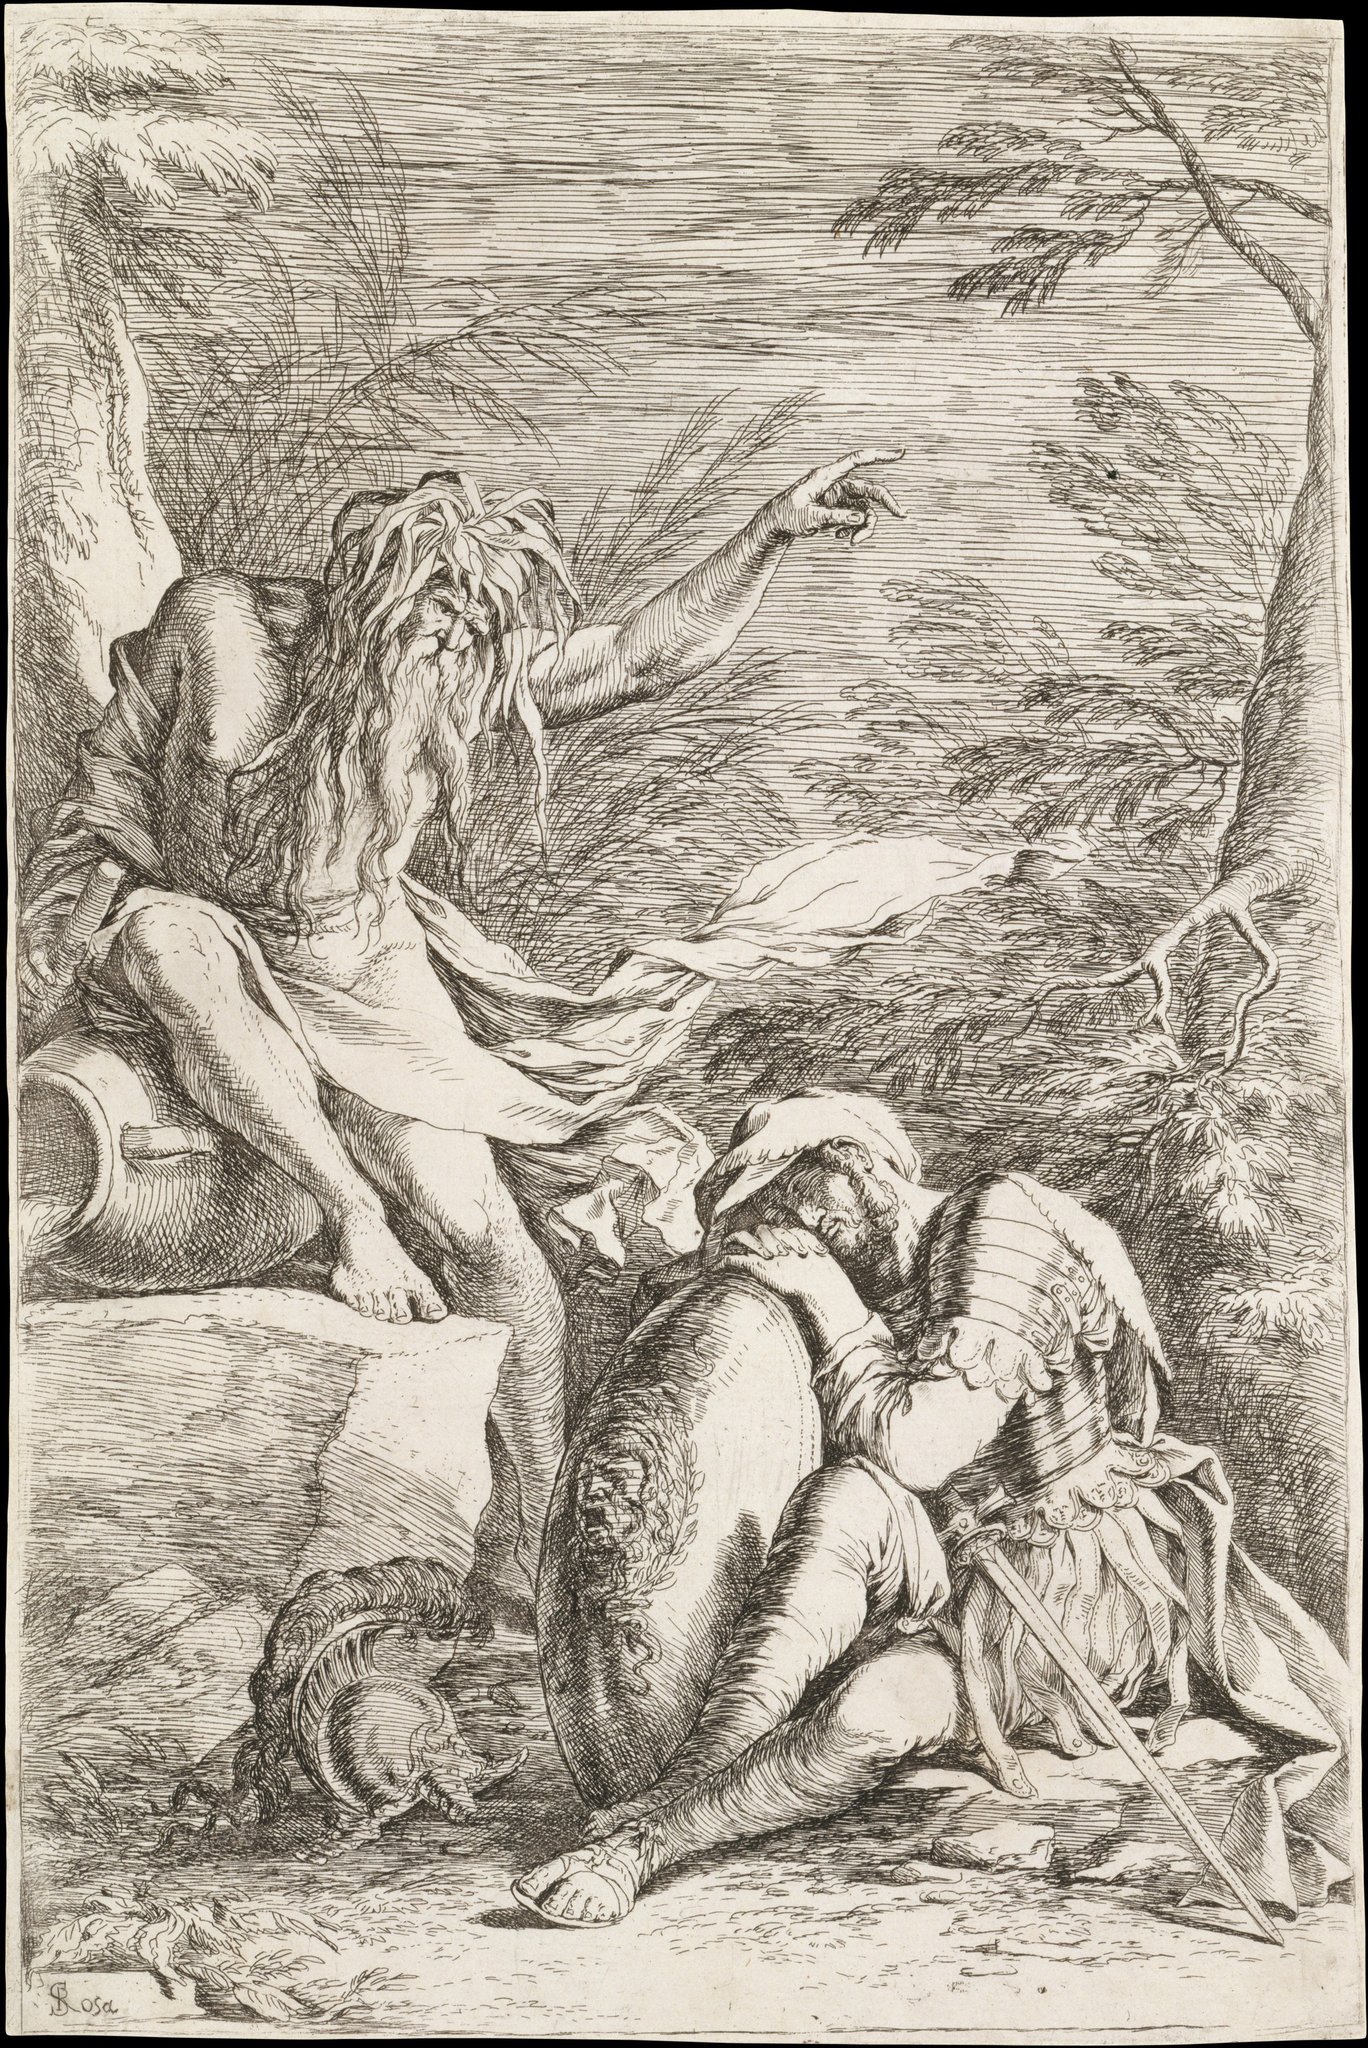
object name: print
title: Dream of Aeneas: Aeneas rests his head on his hands atop his shield, while the river god Tiber leans on a vessel and points upward with his left hand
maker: salvator rosa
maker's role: artist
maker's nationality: italian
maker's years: 1615-1673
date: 1663-1664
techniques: drypoint, etching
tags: sleeping,men,aeneas,aeneid